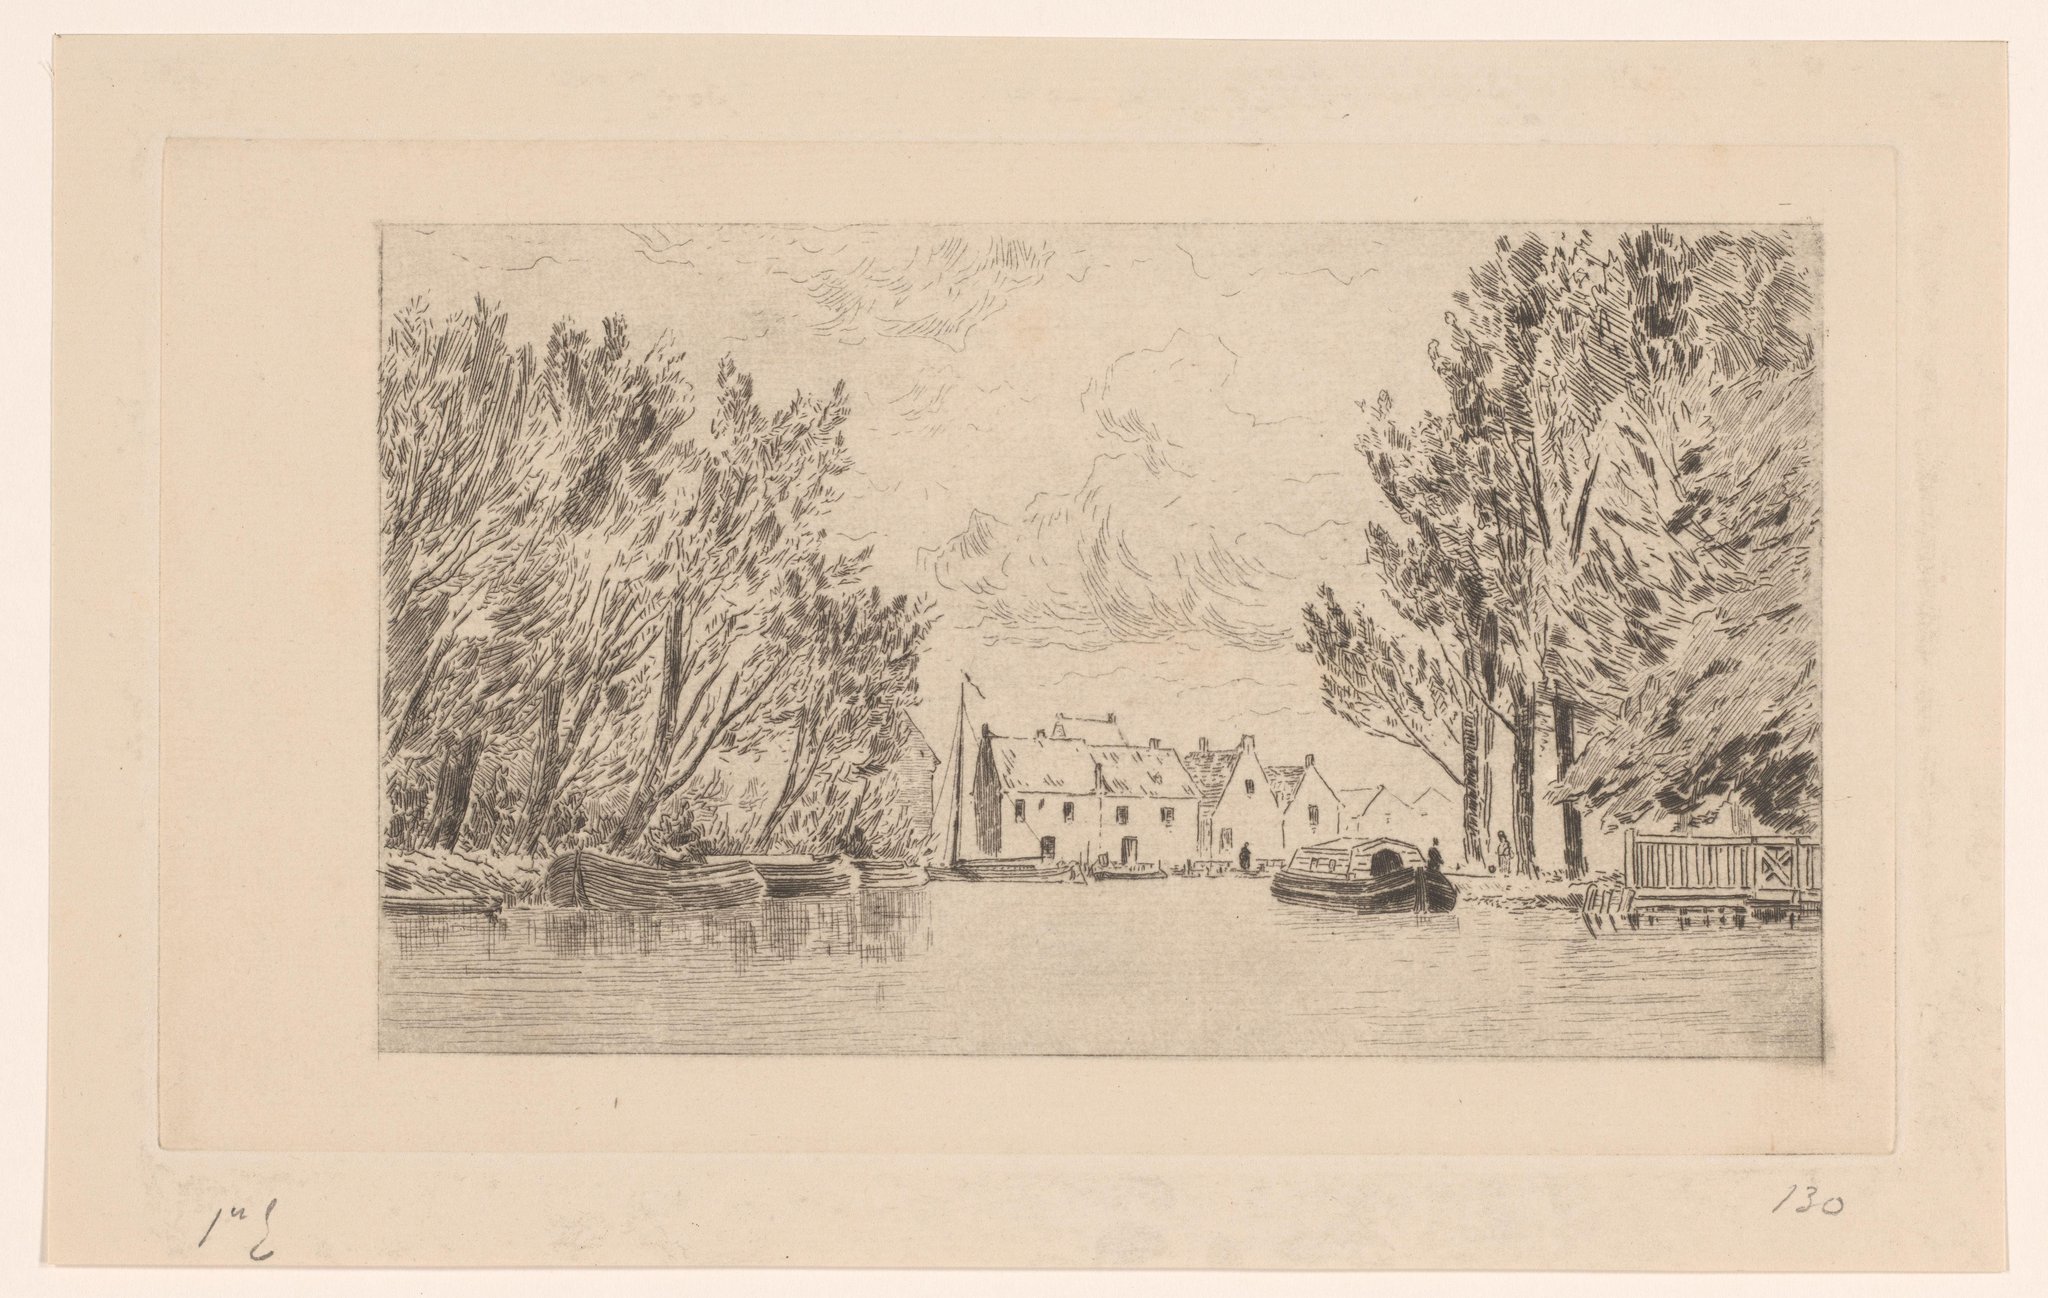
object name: print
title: Crooswijh (Faubourg de Rotterdam)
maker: carel nicolaas storm van s-gravesande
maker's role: draughtsman, print maker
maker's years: 1841-1924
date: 1880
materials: paper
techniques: etching, intaglio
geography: netherlands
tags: canals, waters (in city) (+ city(-scape) with figures, staffage)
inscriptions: collector's mark: Lugt 2228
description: Gezicht op de wijk Crooswijk in Rotterdam. Op de voorgrond liggen boten in het water.